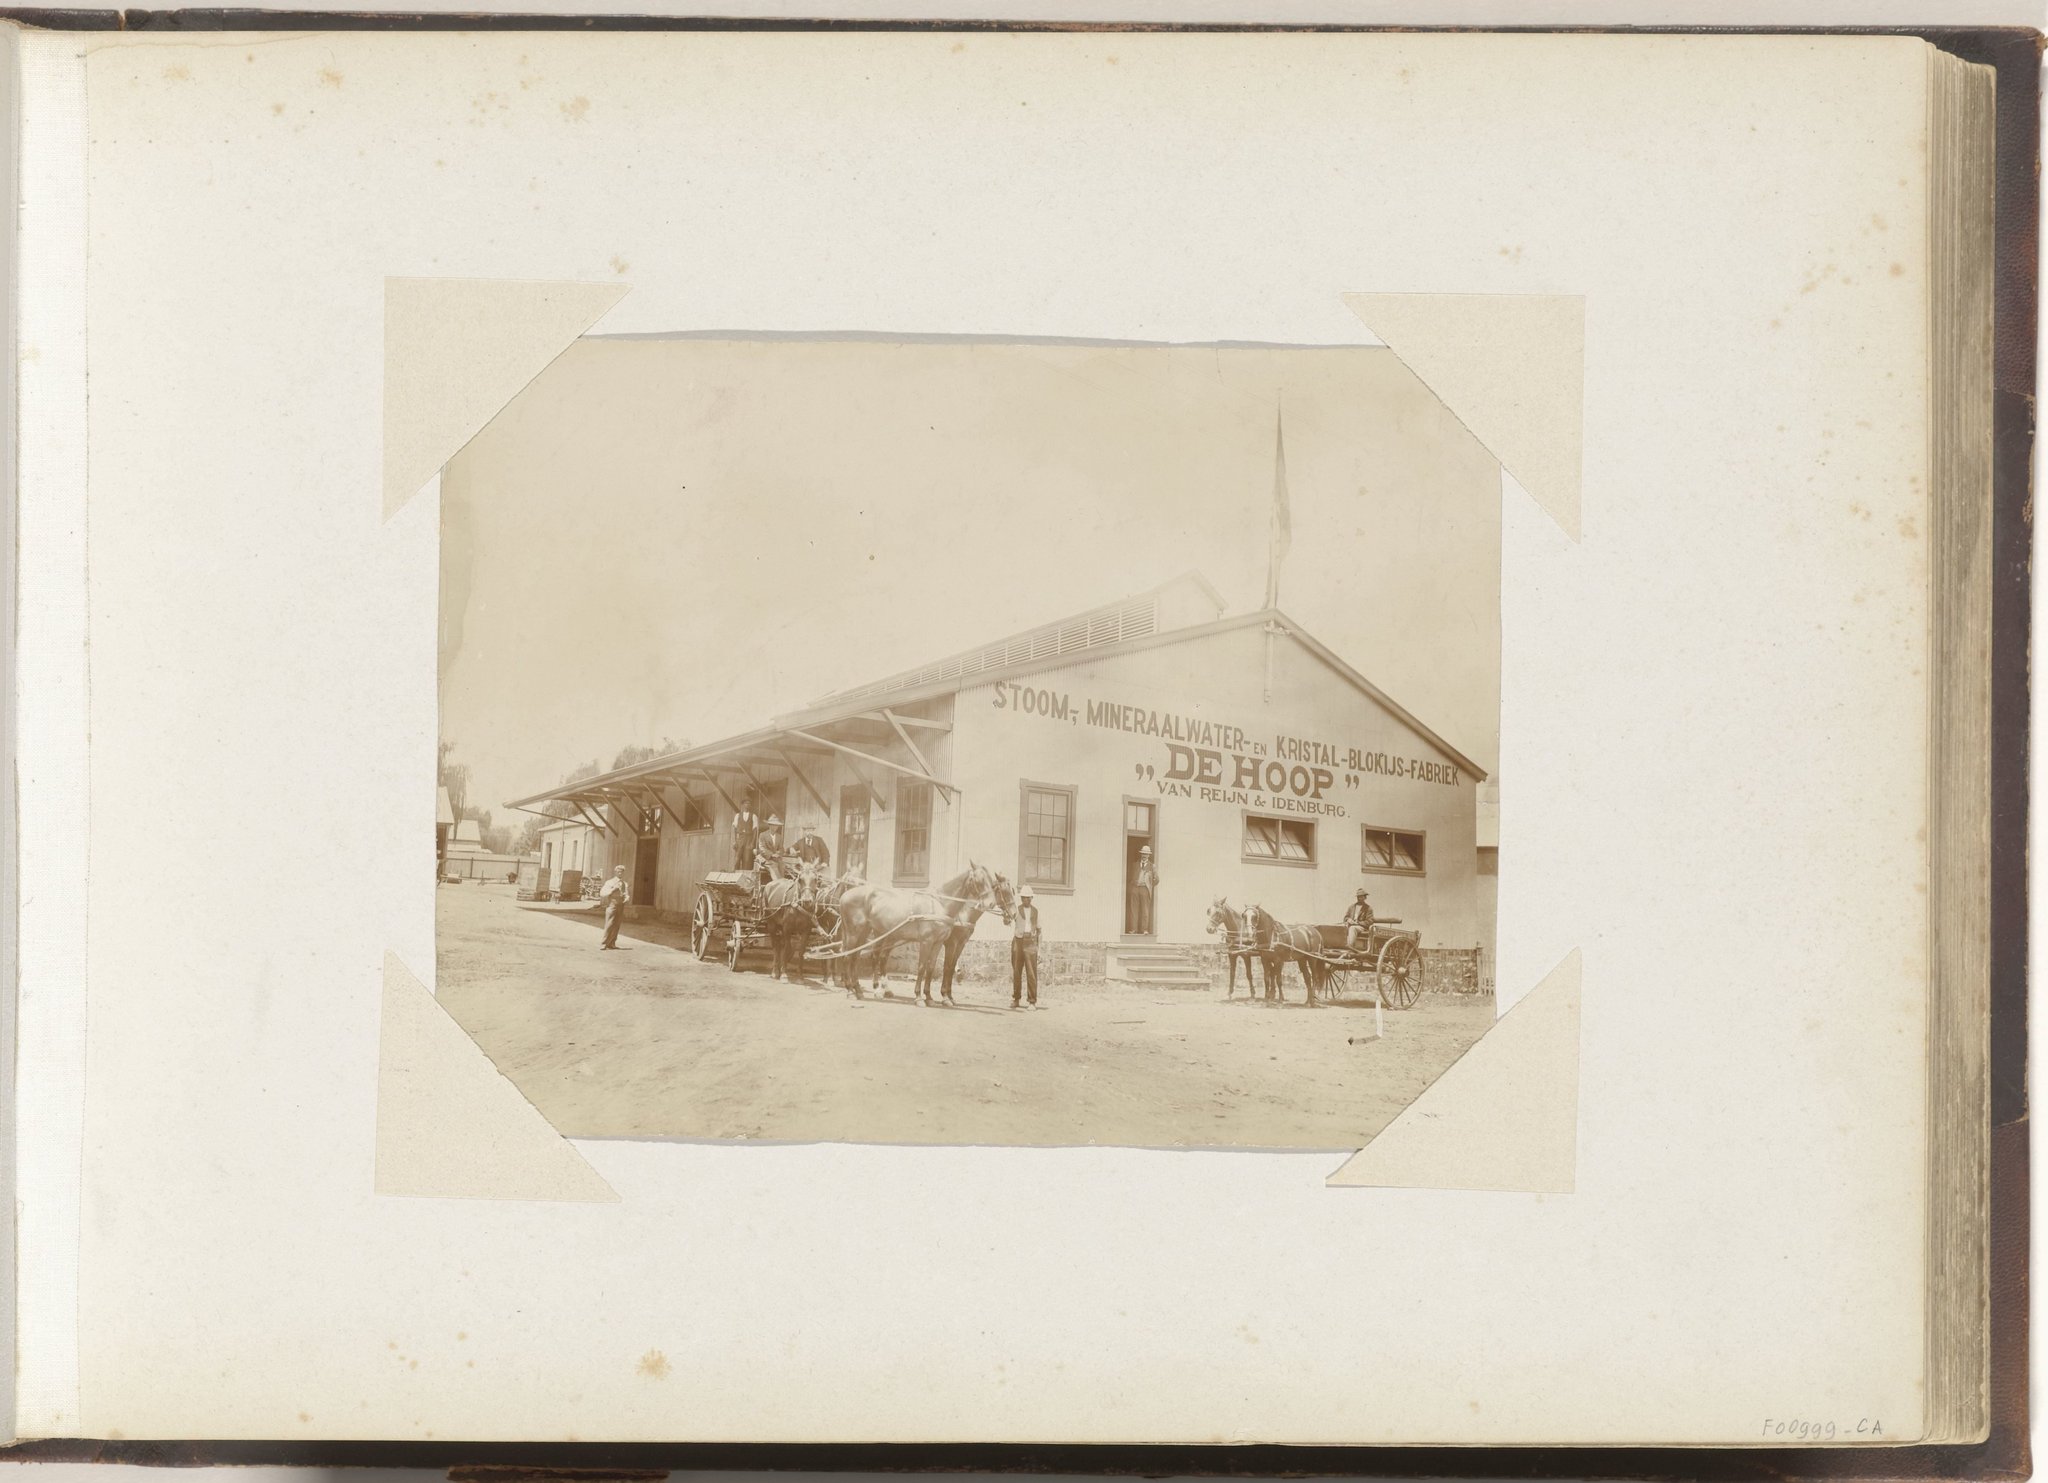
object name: photograph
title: Paarden en wagens voor Stoom-, Mineraalwater en Kristal-Blokijs-Fabriek De Hoop, Van Reijn en Idenburg in Zuid-Afrika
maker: Anonymous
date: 1896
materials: paper, photographic support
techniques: daylight paper print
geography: south africa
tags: animal traction, animal-drawn vehicle (carriage etc.), workshop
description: Onderdeel van Album met 191 foto's van een reis naar en door Zuid-Afrika.